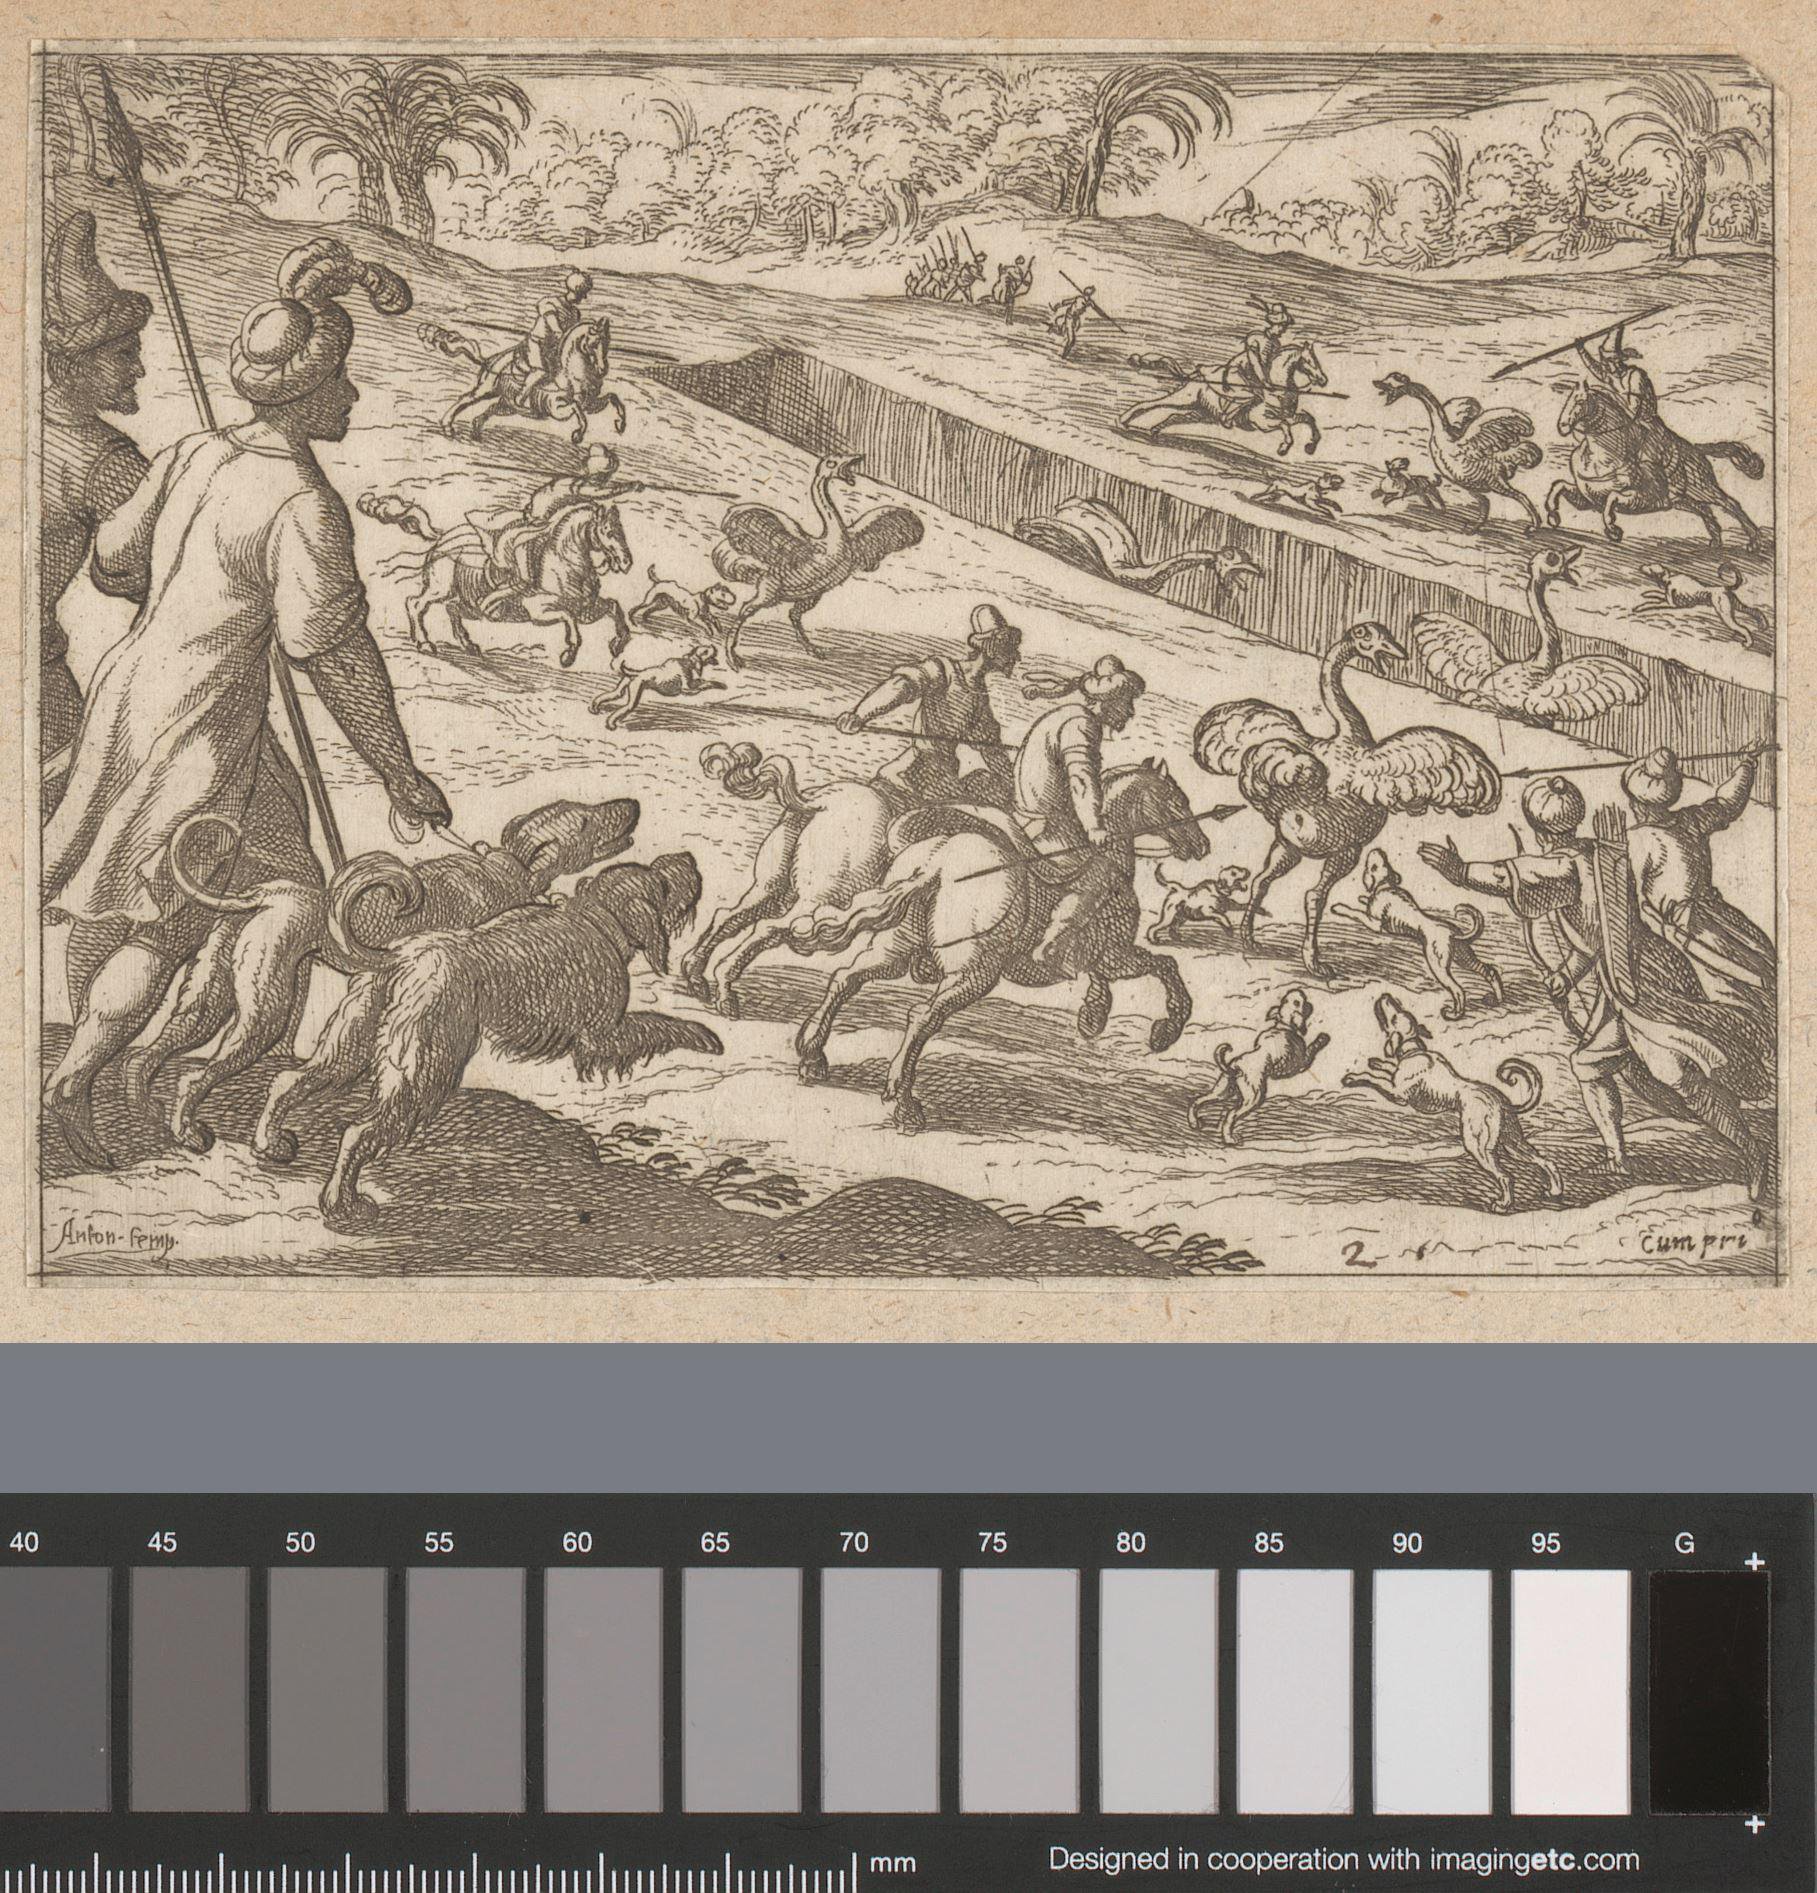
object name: print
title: Primo libro di caccie varie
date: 1598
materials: paper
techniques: etching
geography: vatican city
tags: walker and runner birds: ostrich, hunter, hunters hunting (n.b.: in 1988-1990 this notation denoted the concept of 43c11421 'hunters resting during the hunt'), bird hunting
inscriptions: number: ‘2’, collector's mark: ‘Hinloopen’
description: Deze prent maakt deel uit van een reeks van 45 jachtscènes (+ titelprent en opdracht).